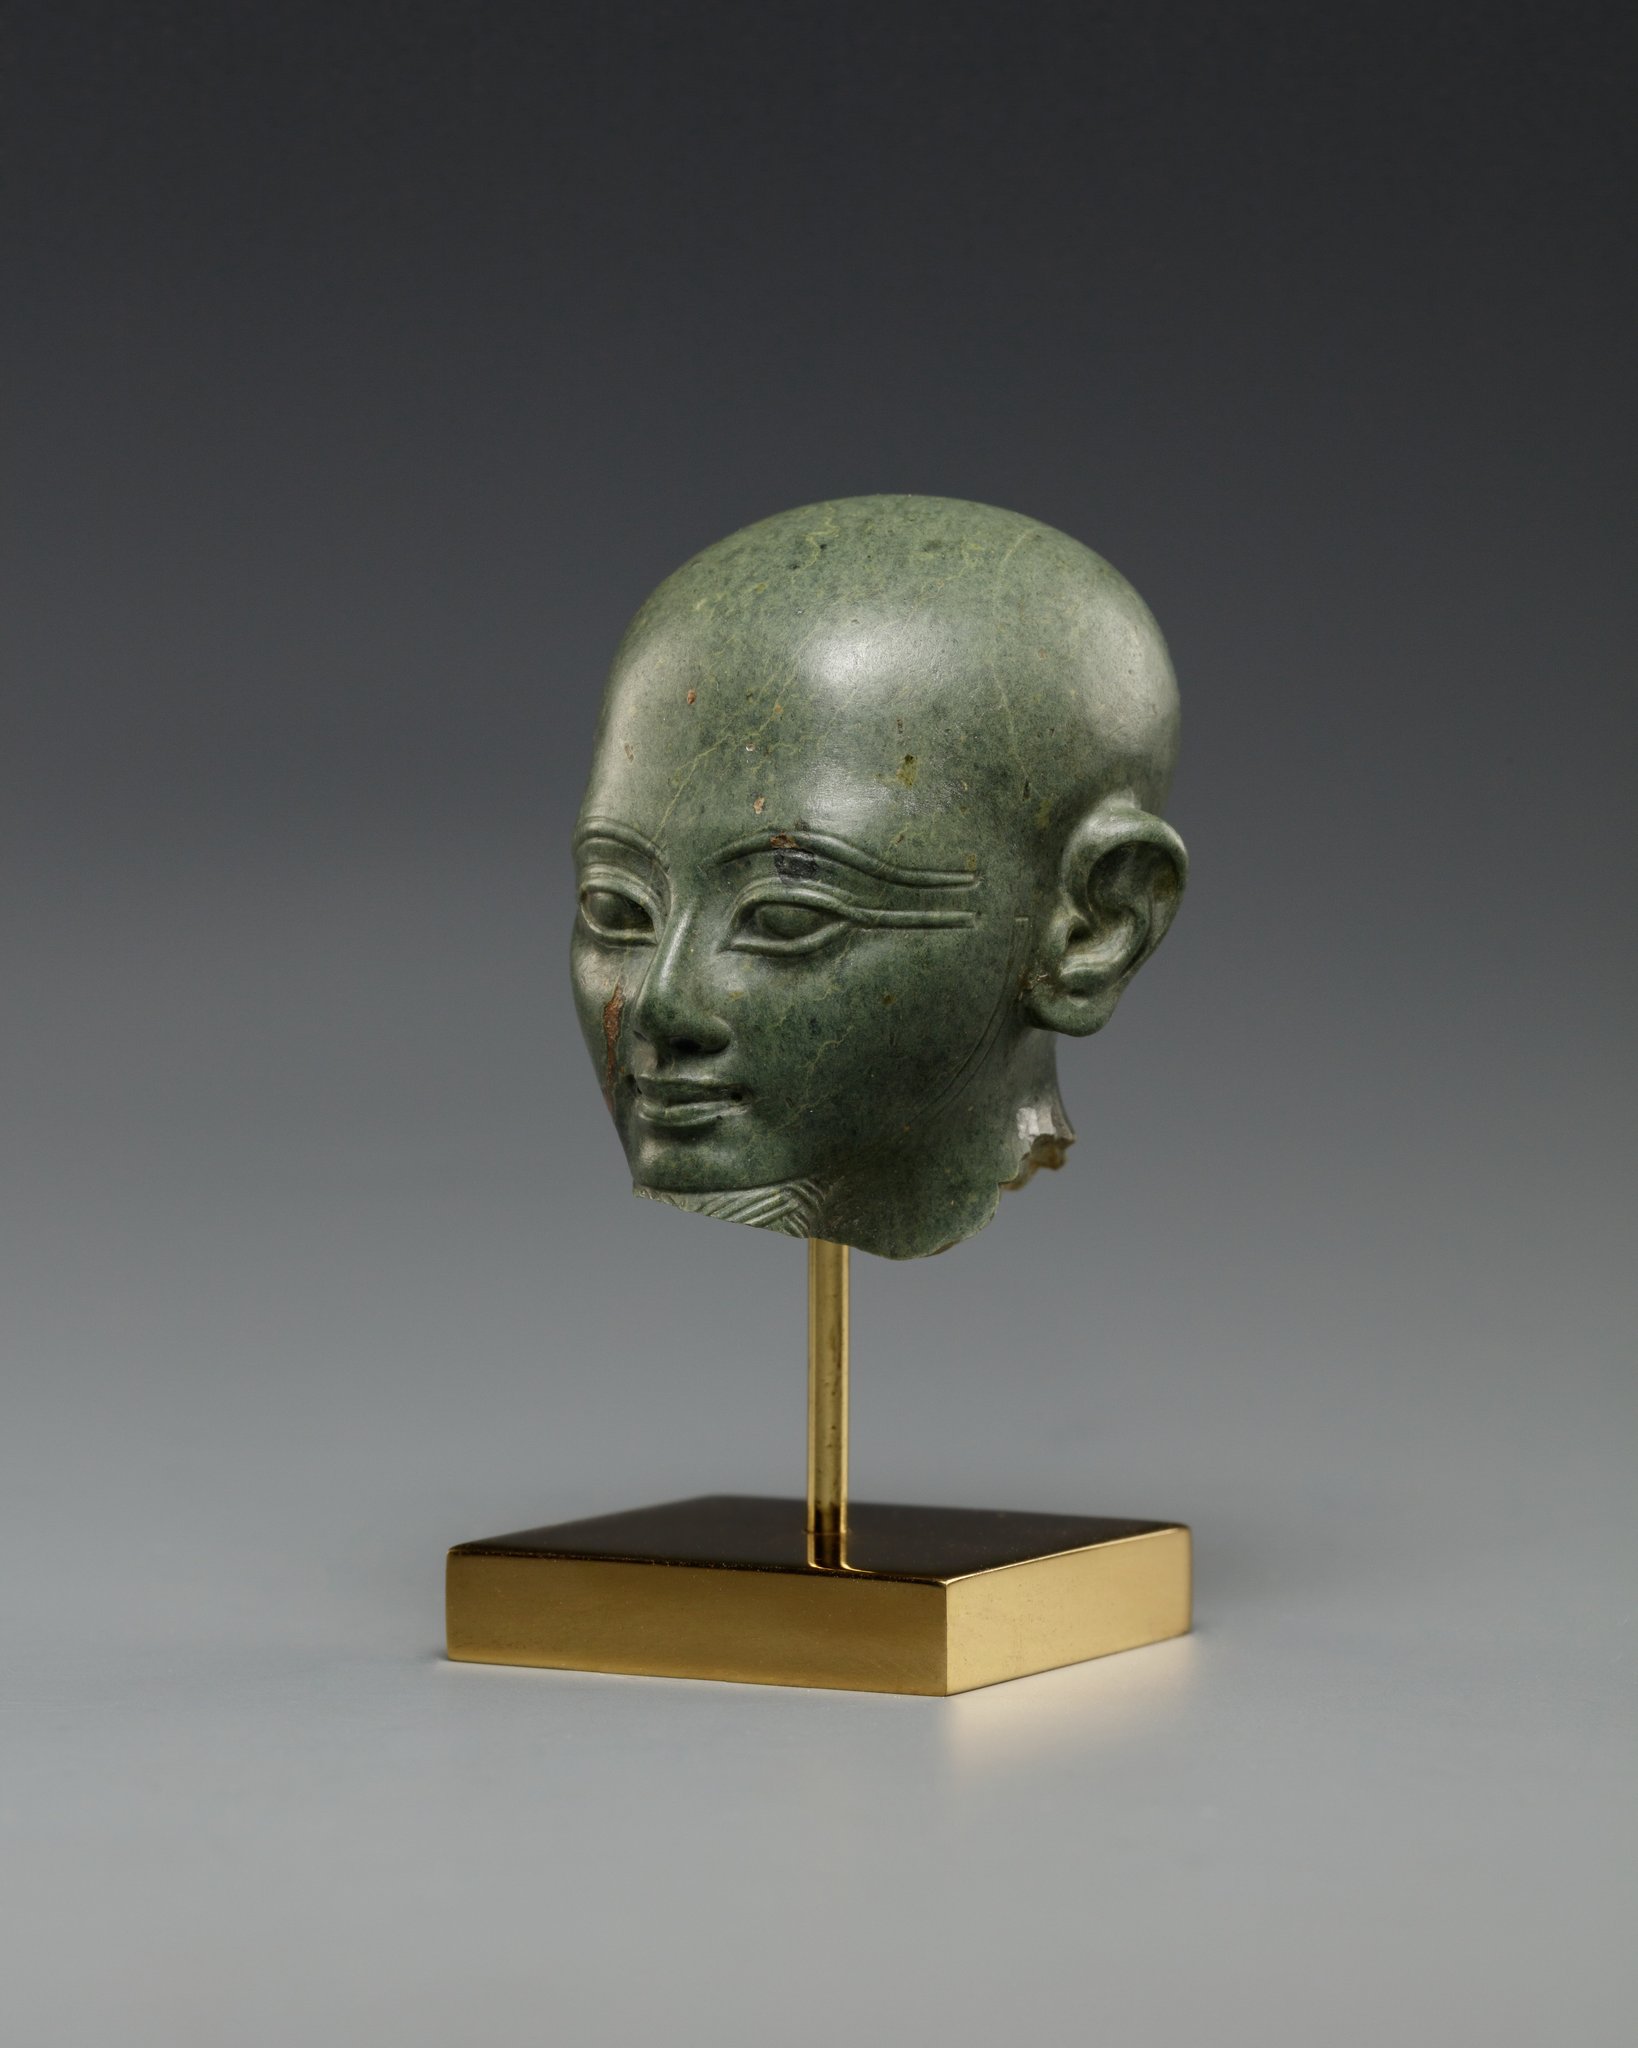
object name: head, ptah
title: Head of a Statuette of Ptah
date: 1295-1070 BCE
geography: egypt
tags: heads